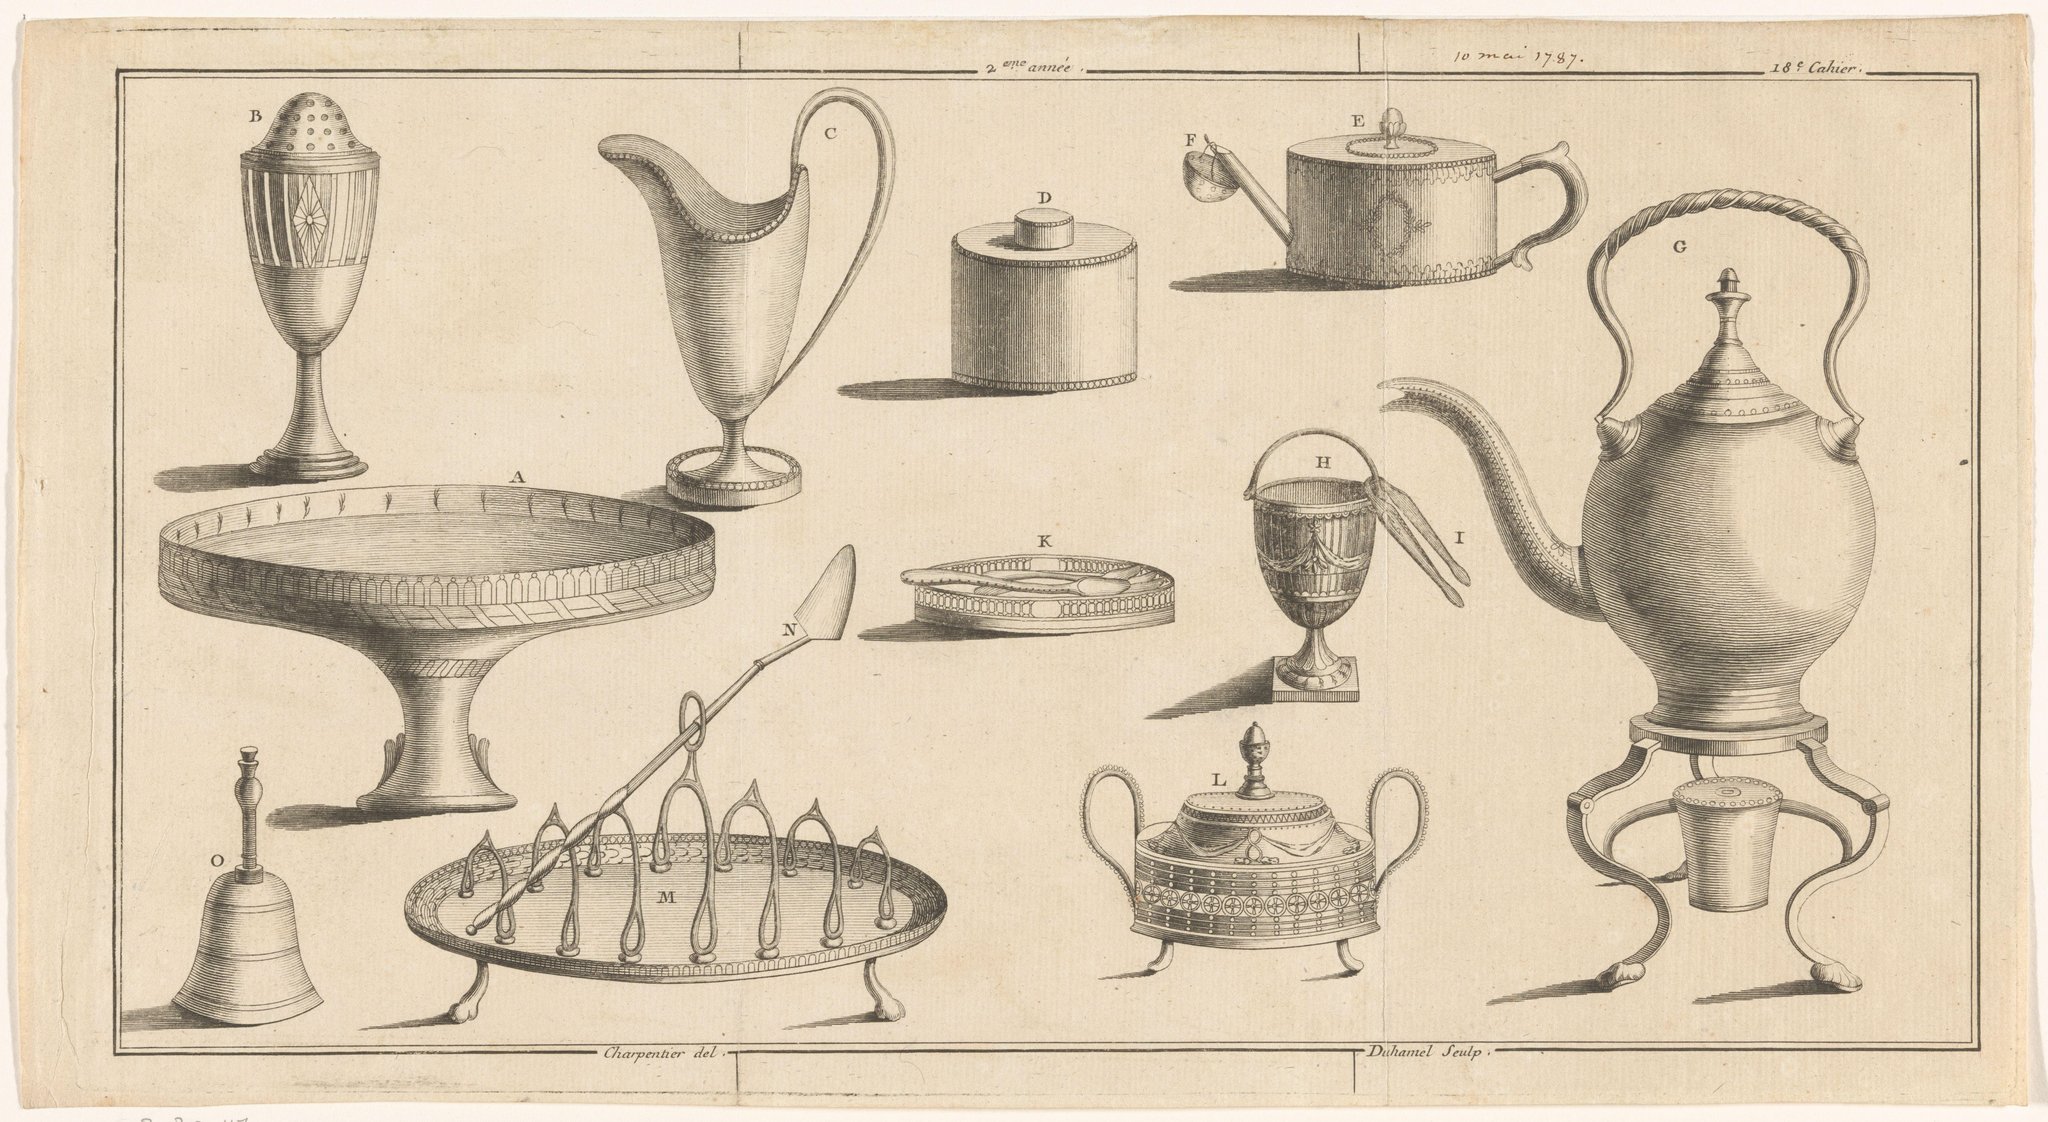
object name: print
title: Ontwerpen voor zilverwerk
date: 1787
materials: paper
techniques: etching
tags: jeweller, goldsmith, silversmith (+ precious metals ~ arts)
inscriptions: : ‘2eme année / 18e Cahier’, collector's mark: Lugt 2228, signature: ‘Charpentier del’, collector's mark: Lugt 2760, signature: ‘Duhamel Sculp’, date: ‘10 mei 1787’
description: Veertien ontwerpen voor zilver servies. De ontwerpen zijn aangeduid met de letter A tot en met O. De prent is van het 18e cahier, 2e année, van een Frans tijdschrift.